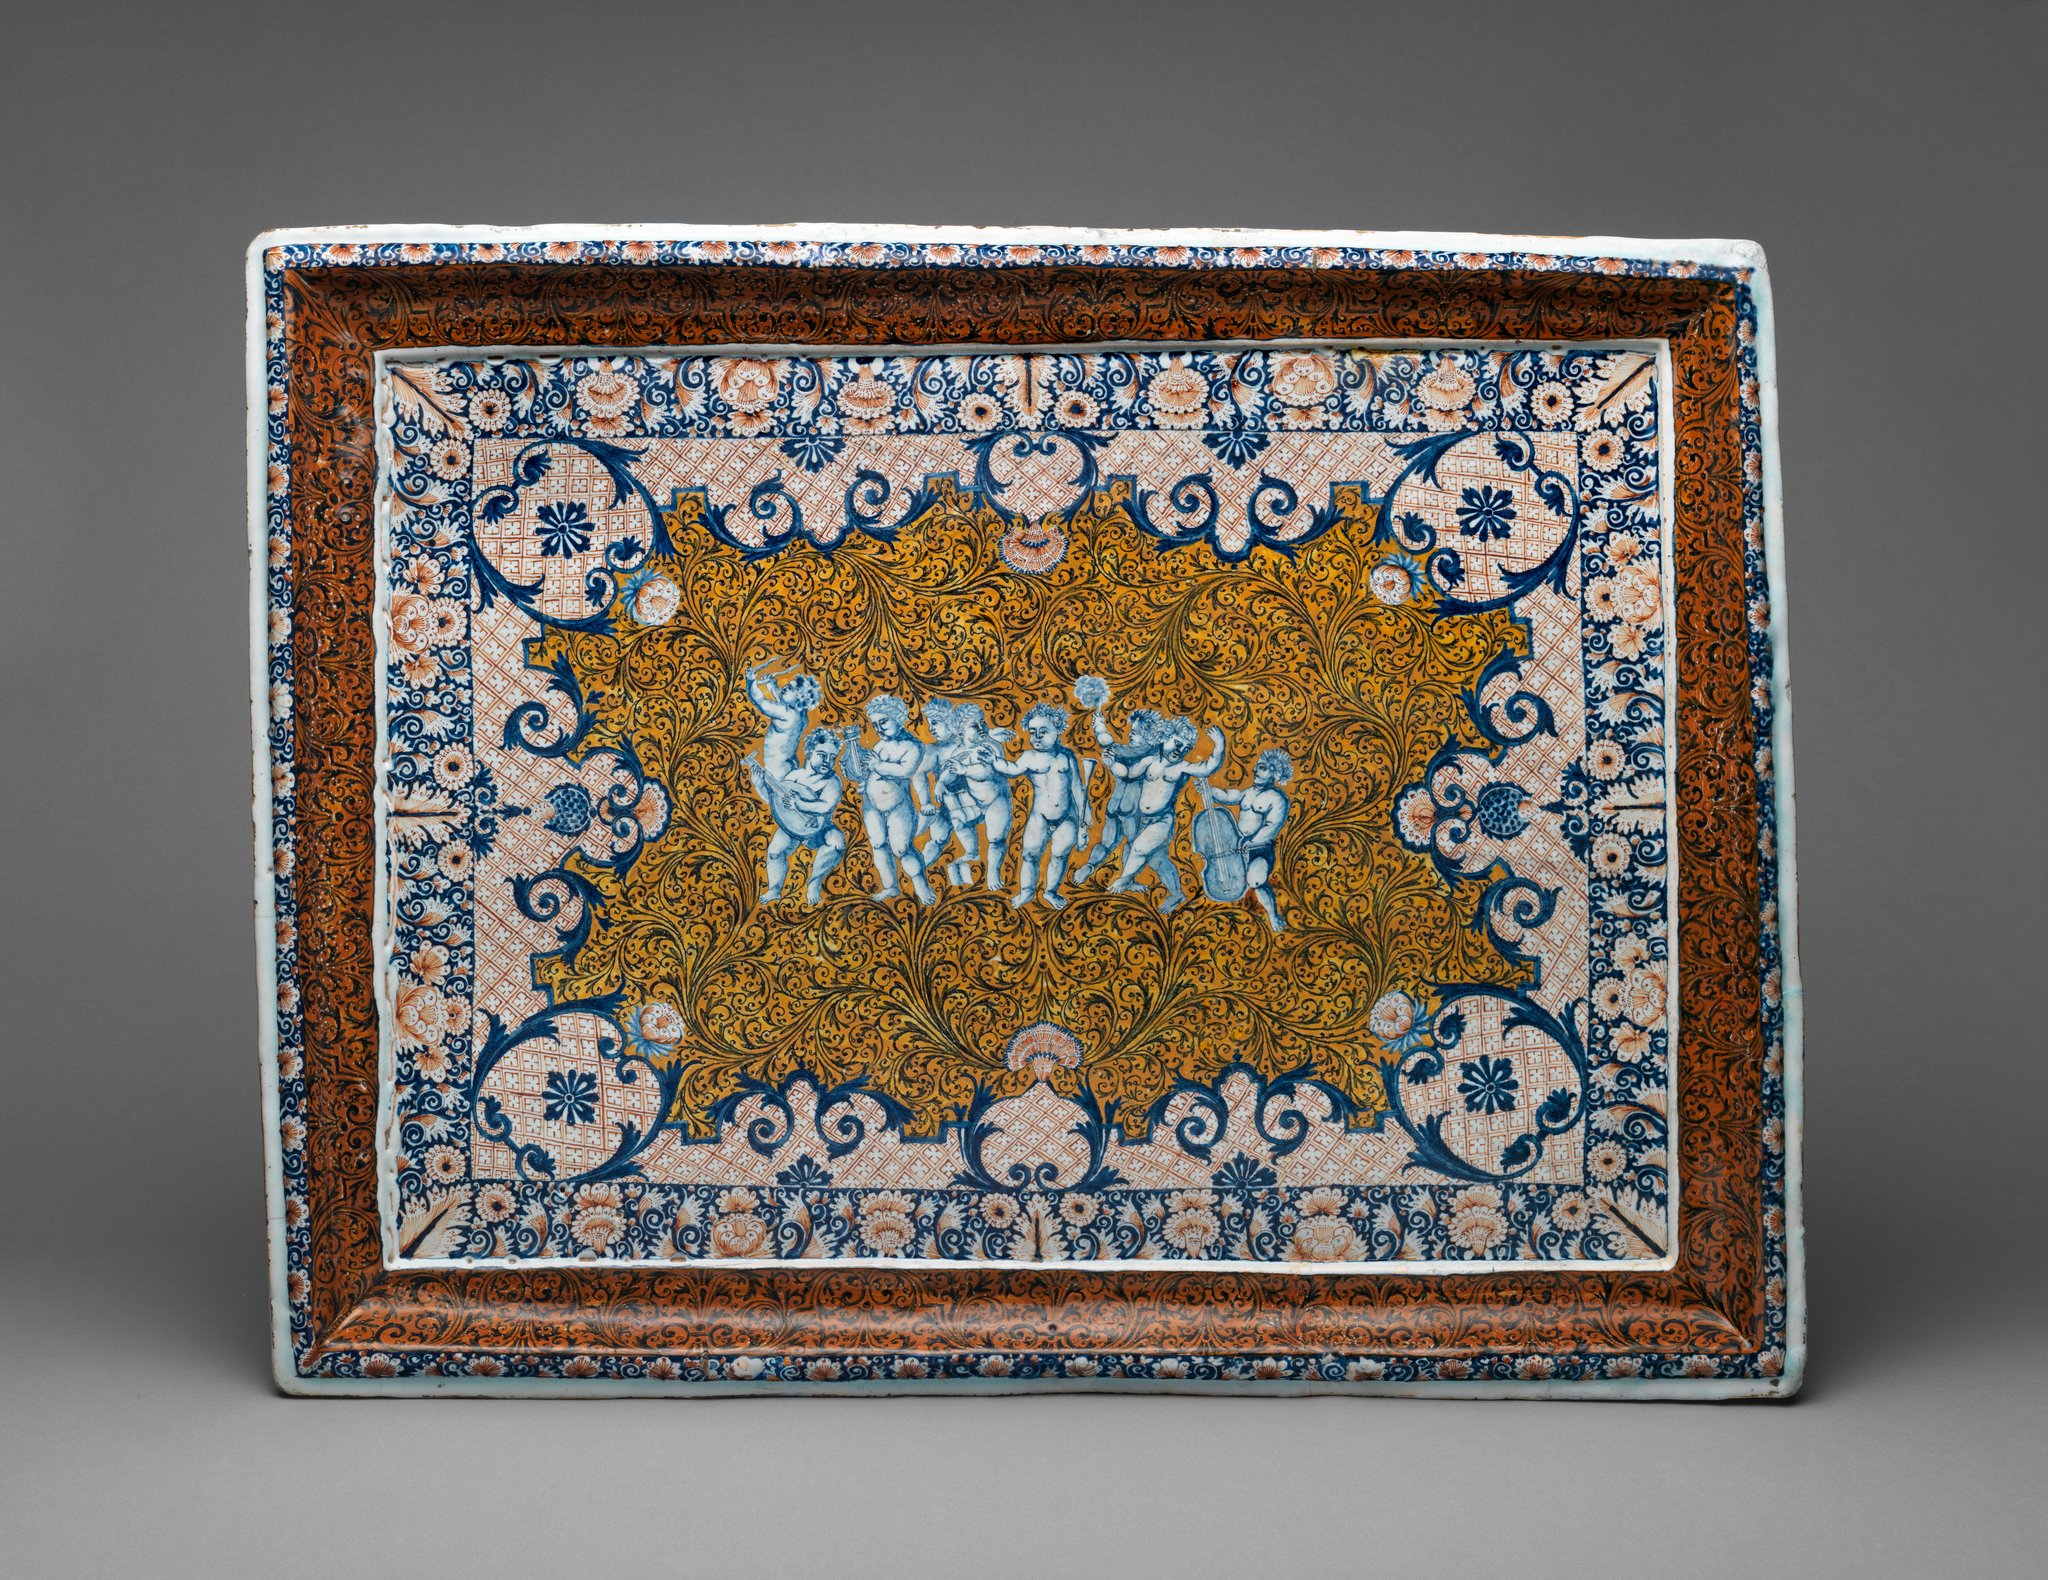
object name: tea tray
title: Tea tray (Plateau)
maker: pierre brebiette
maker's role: artist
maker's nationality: french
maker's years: 1598-1642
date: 1725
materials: faience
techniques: glazing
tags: musical instruments,children,lutes